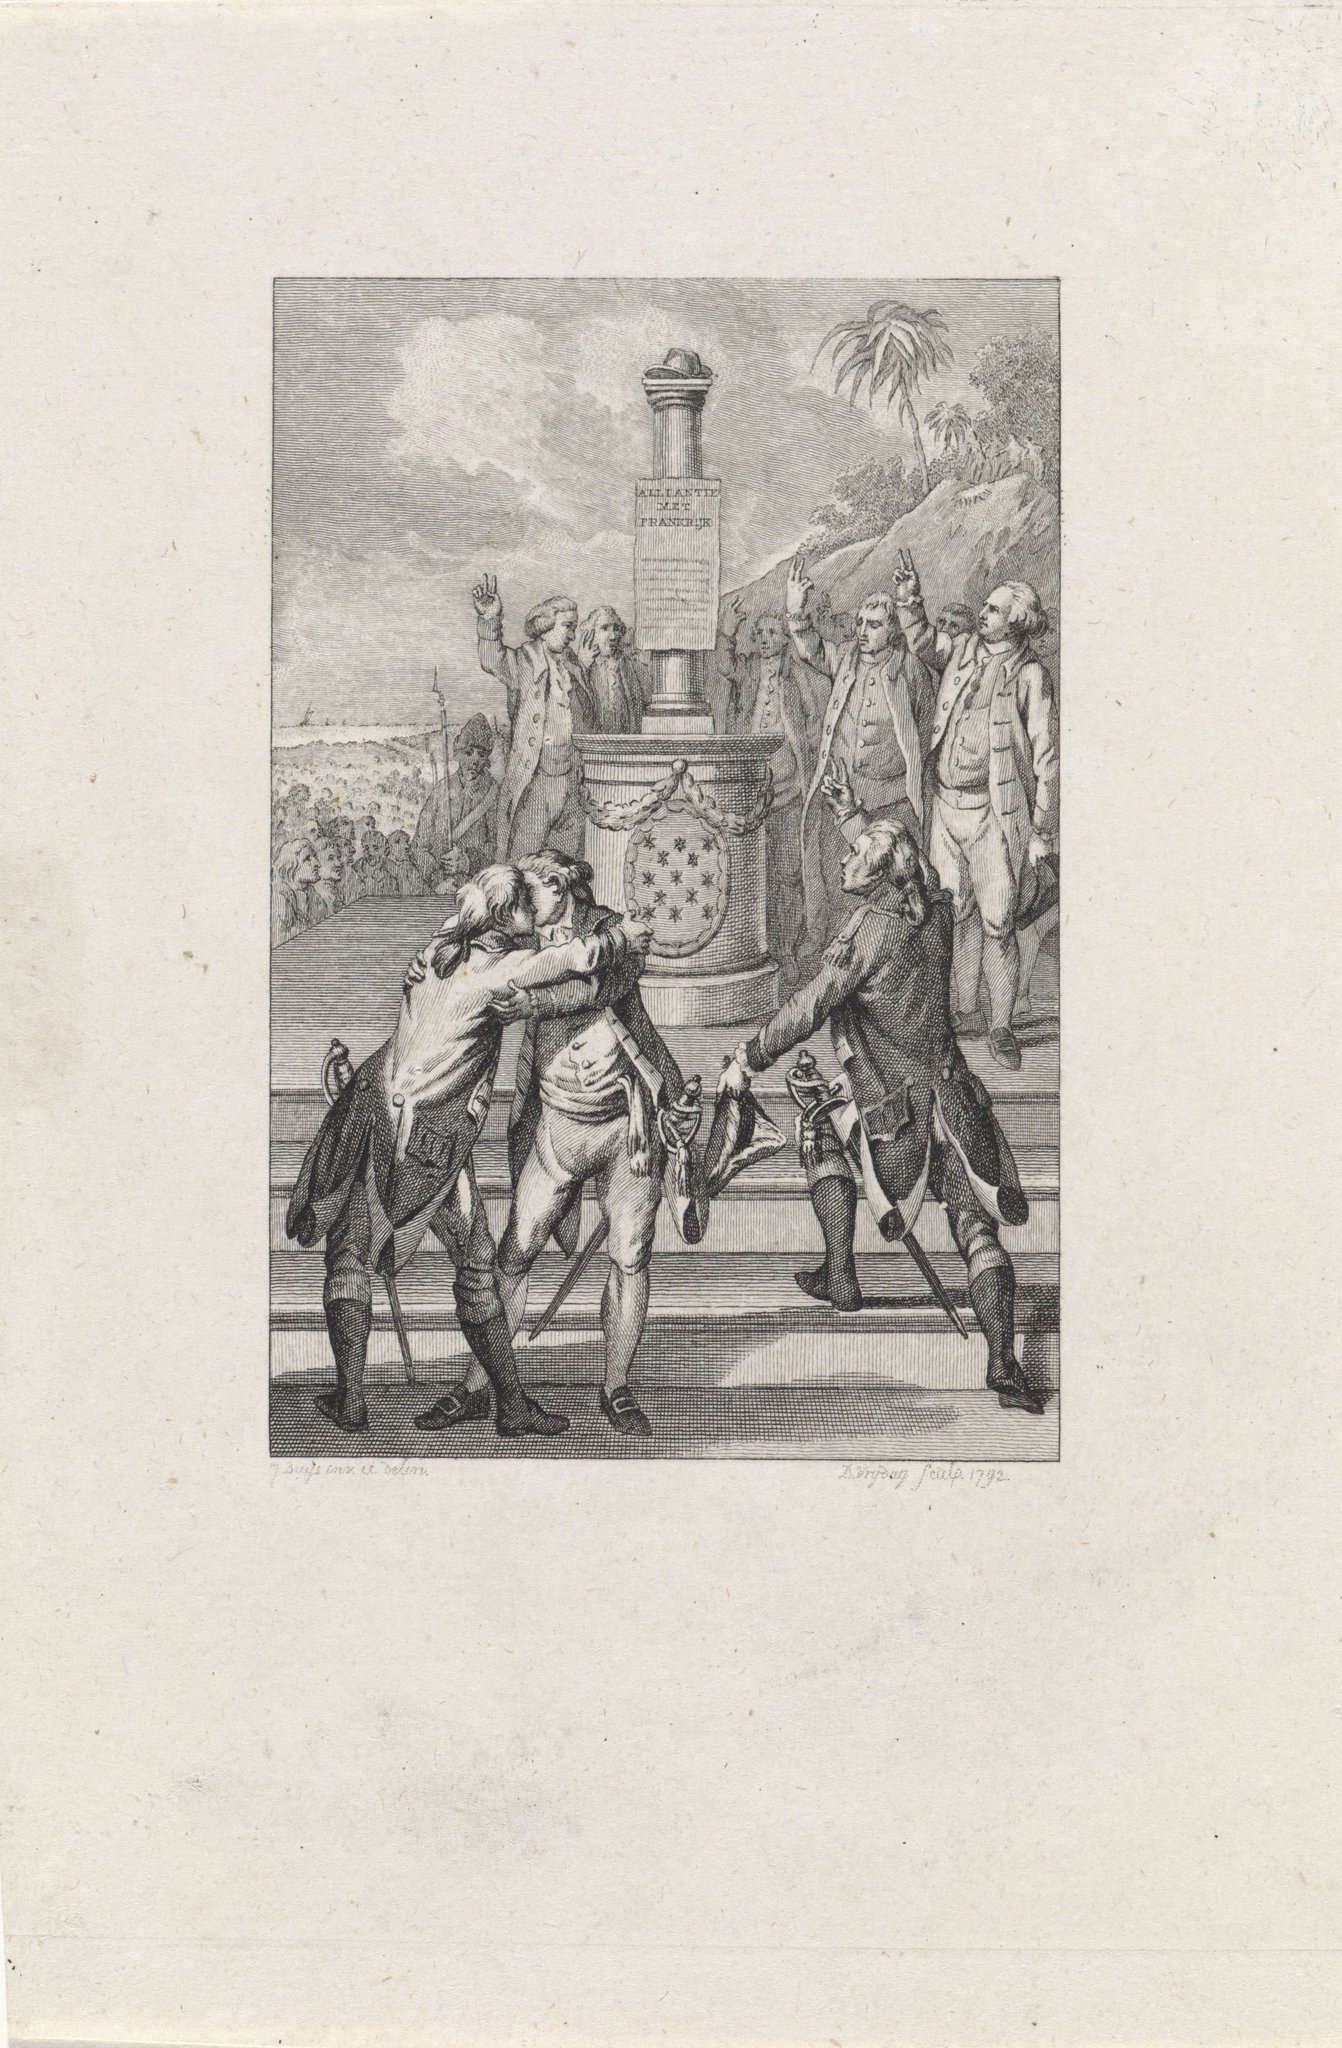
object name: print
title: Koning Willem III bij een zitting van het Hogerhuis, 1689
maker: cornelis huyberts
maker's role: print maker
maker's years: 1669-1709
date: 1689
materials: paper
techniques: engraving, etching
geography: northern netherlands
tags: the hague, william iii (prince of orange and king of england, scotland, and ireland), london, maria ii stuart (koningin van engeland, schotland en ierland), upper house, senate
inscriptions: date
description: Koning Willem III gezeten op de troon woont een zitting van het Hogerhuis bij, 1689. In het midden en links en rechts zitten de Lords op kussens. Vooraan de griffiers rond een tafel. Bovenaan de maagd Britannica in de wolken met de portretten van Koning Willem III en koningin Maria II Stuart, links en rechts de Faam.